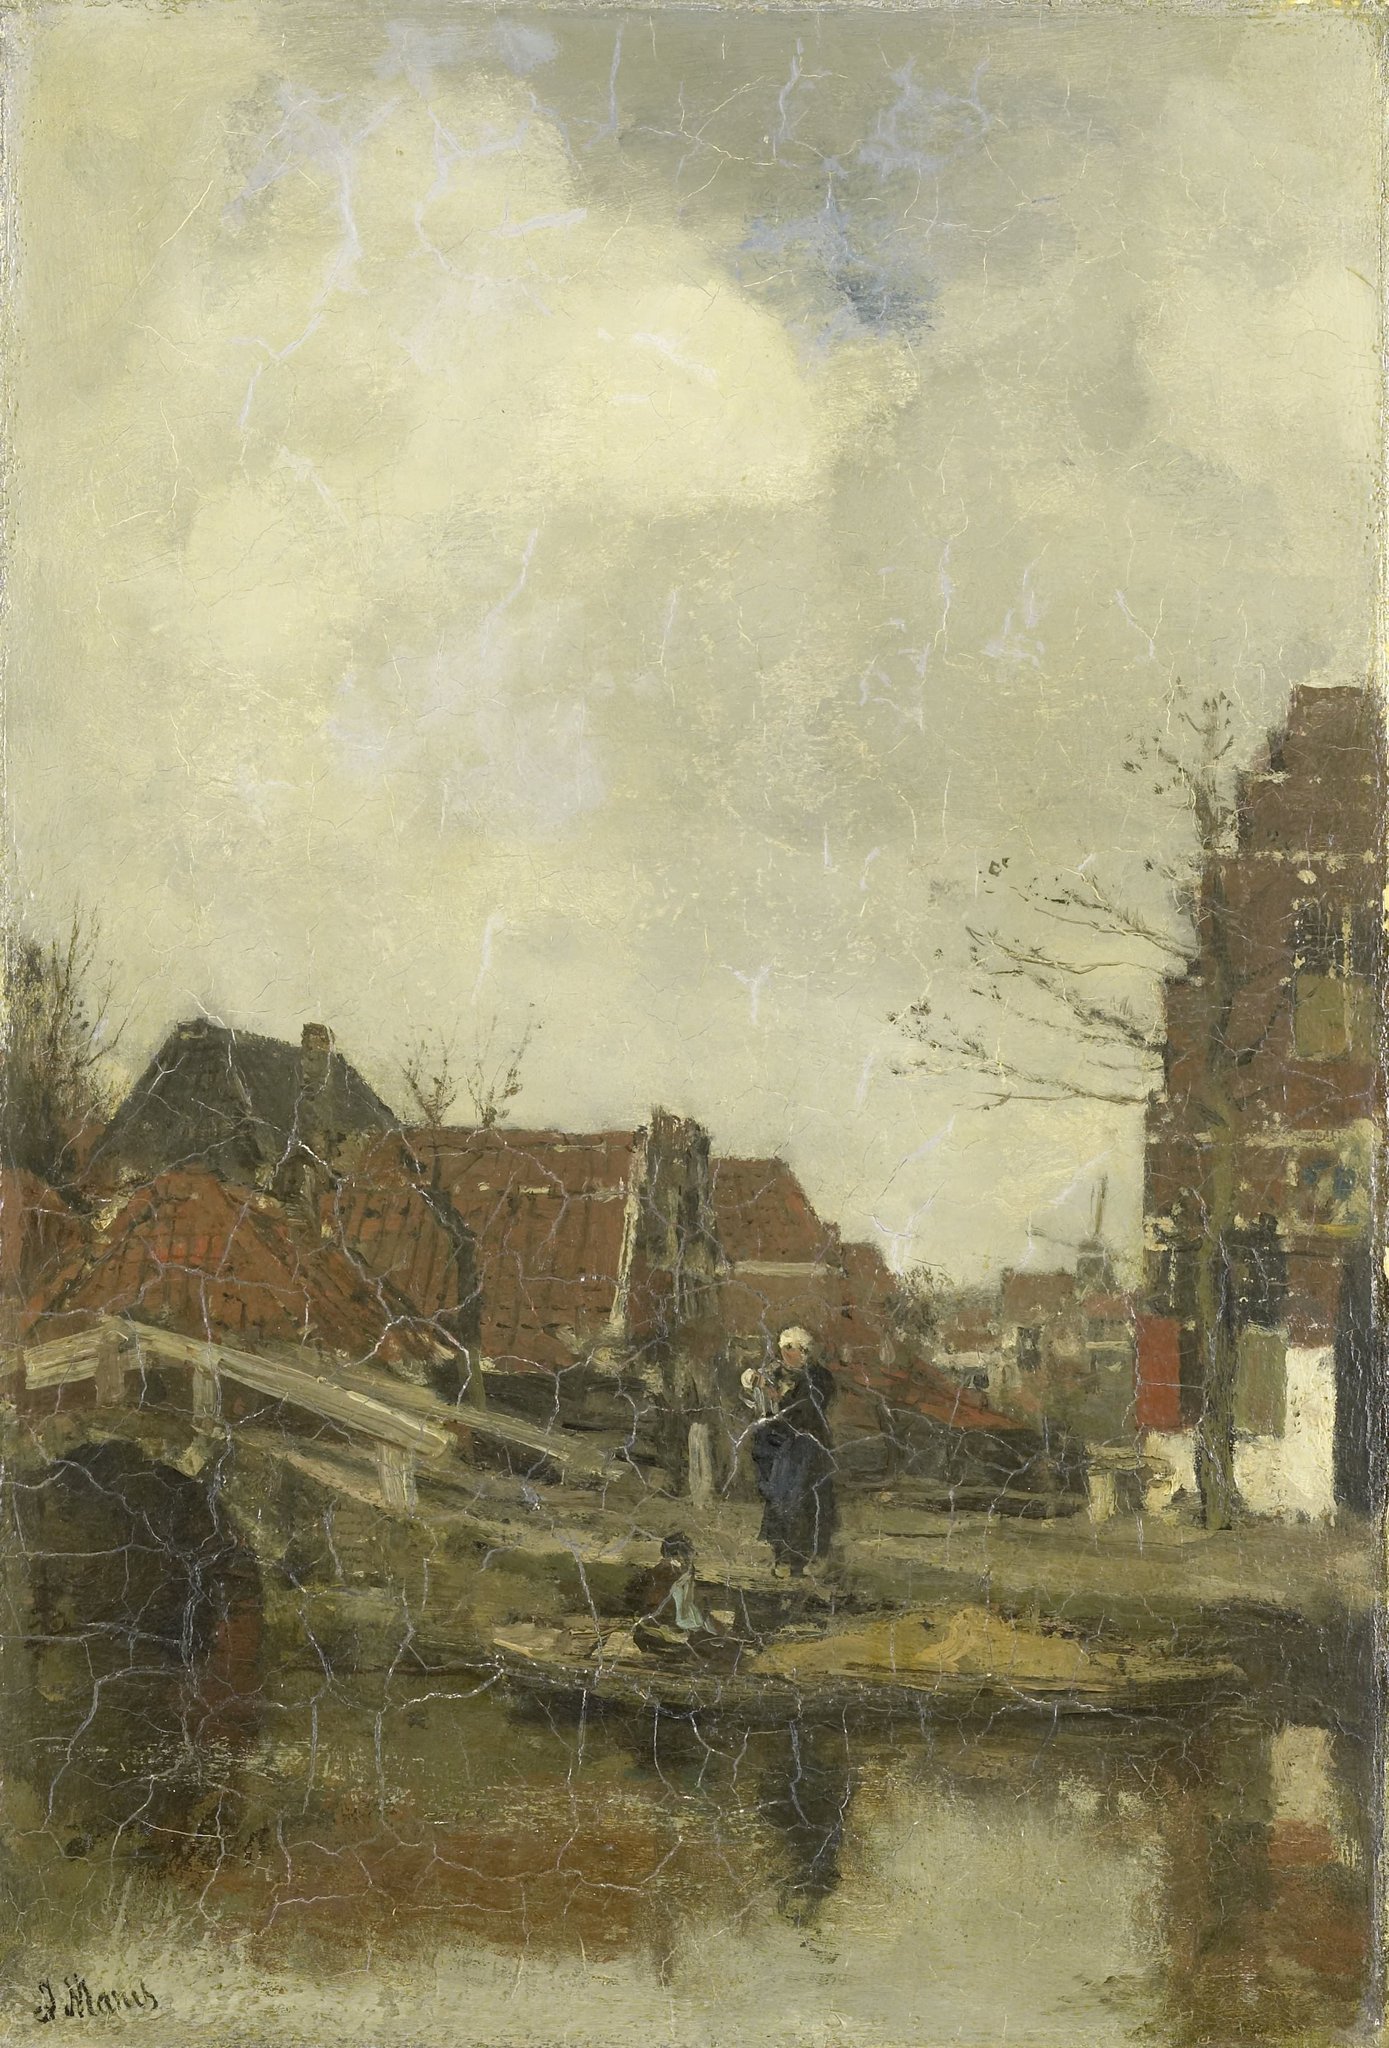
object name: painting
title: Oud buurtje aan het water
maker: jacob maris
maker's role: draughtsman, painter, print maker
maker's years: 1837-1899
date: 1883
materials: canvas, oil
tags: landscape with bridge, viaduct or aqueduct (+ city(-scape) with figures, staffage)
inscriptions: signature: ‘J Maris’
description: Oud buurtje aan het water. Gezicht over een kanaal naar een brug, huizen en schuren. Aan de wal ligt een kleine boot waarin een man zit die met een vrouw praat. In de verte een molen.